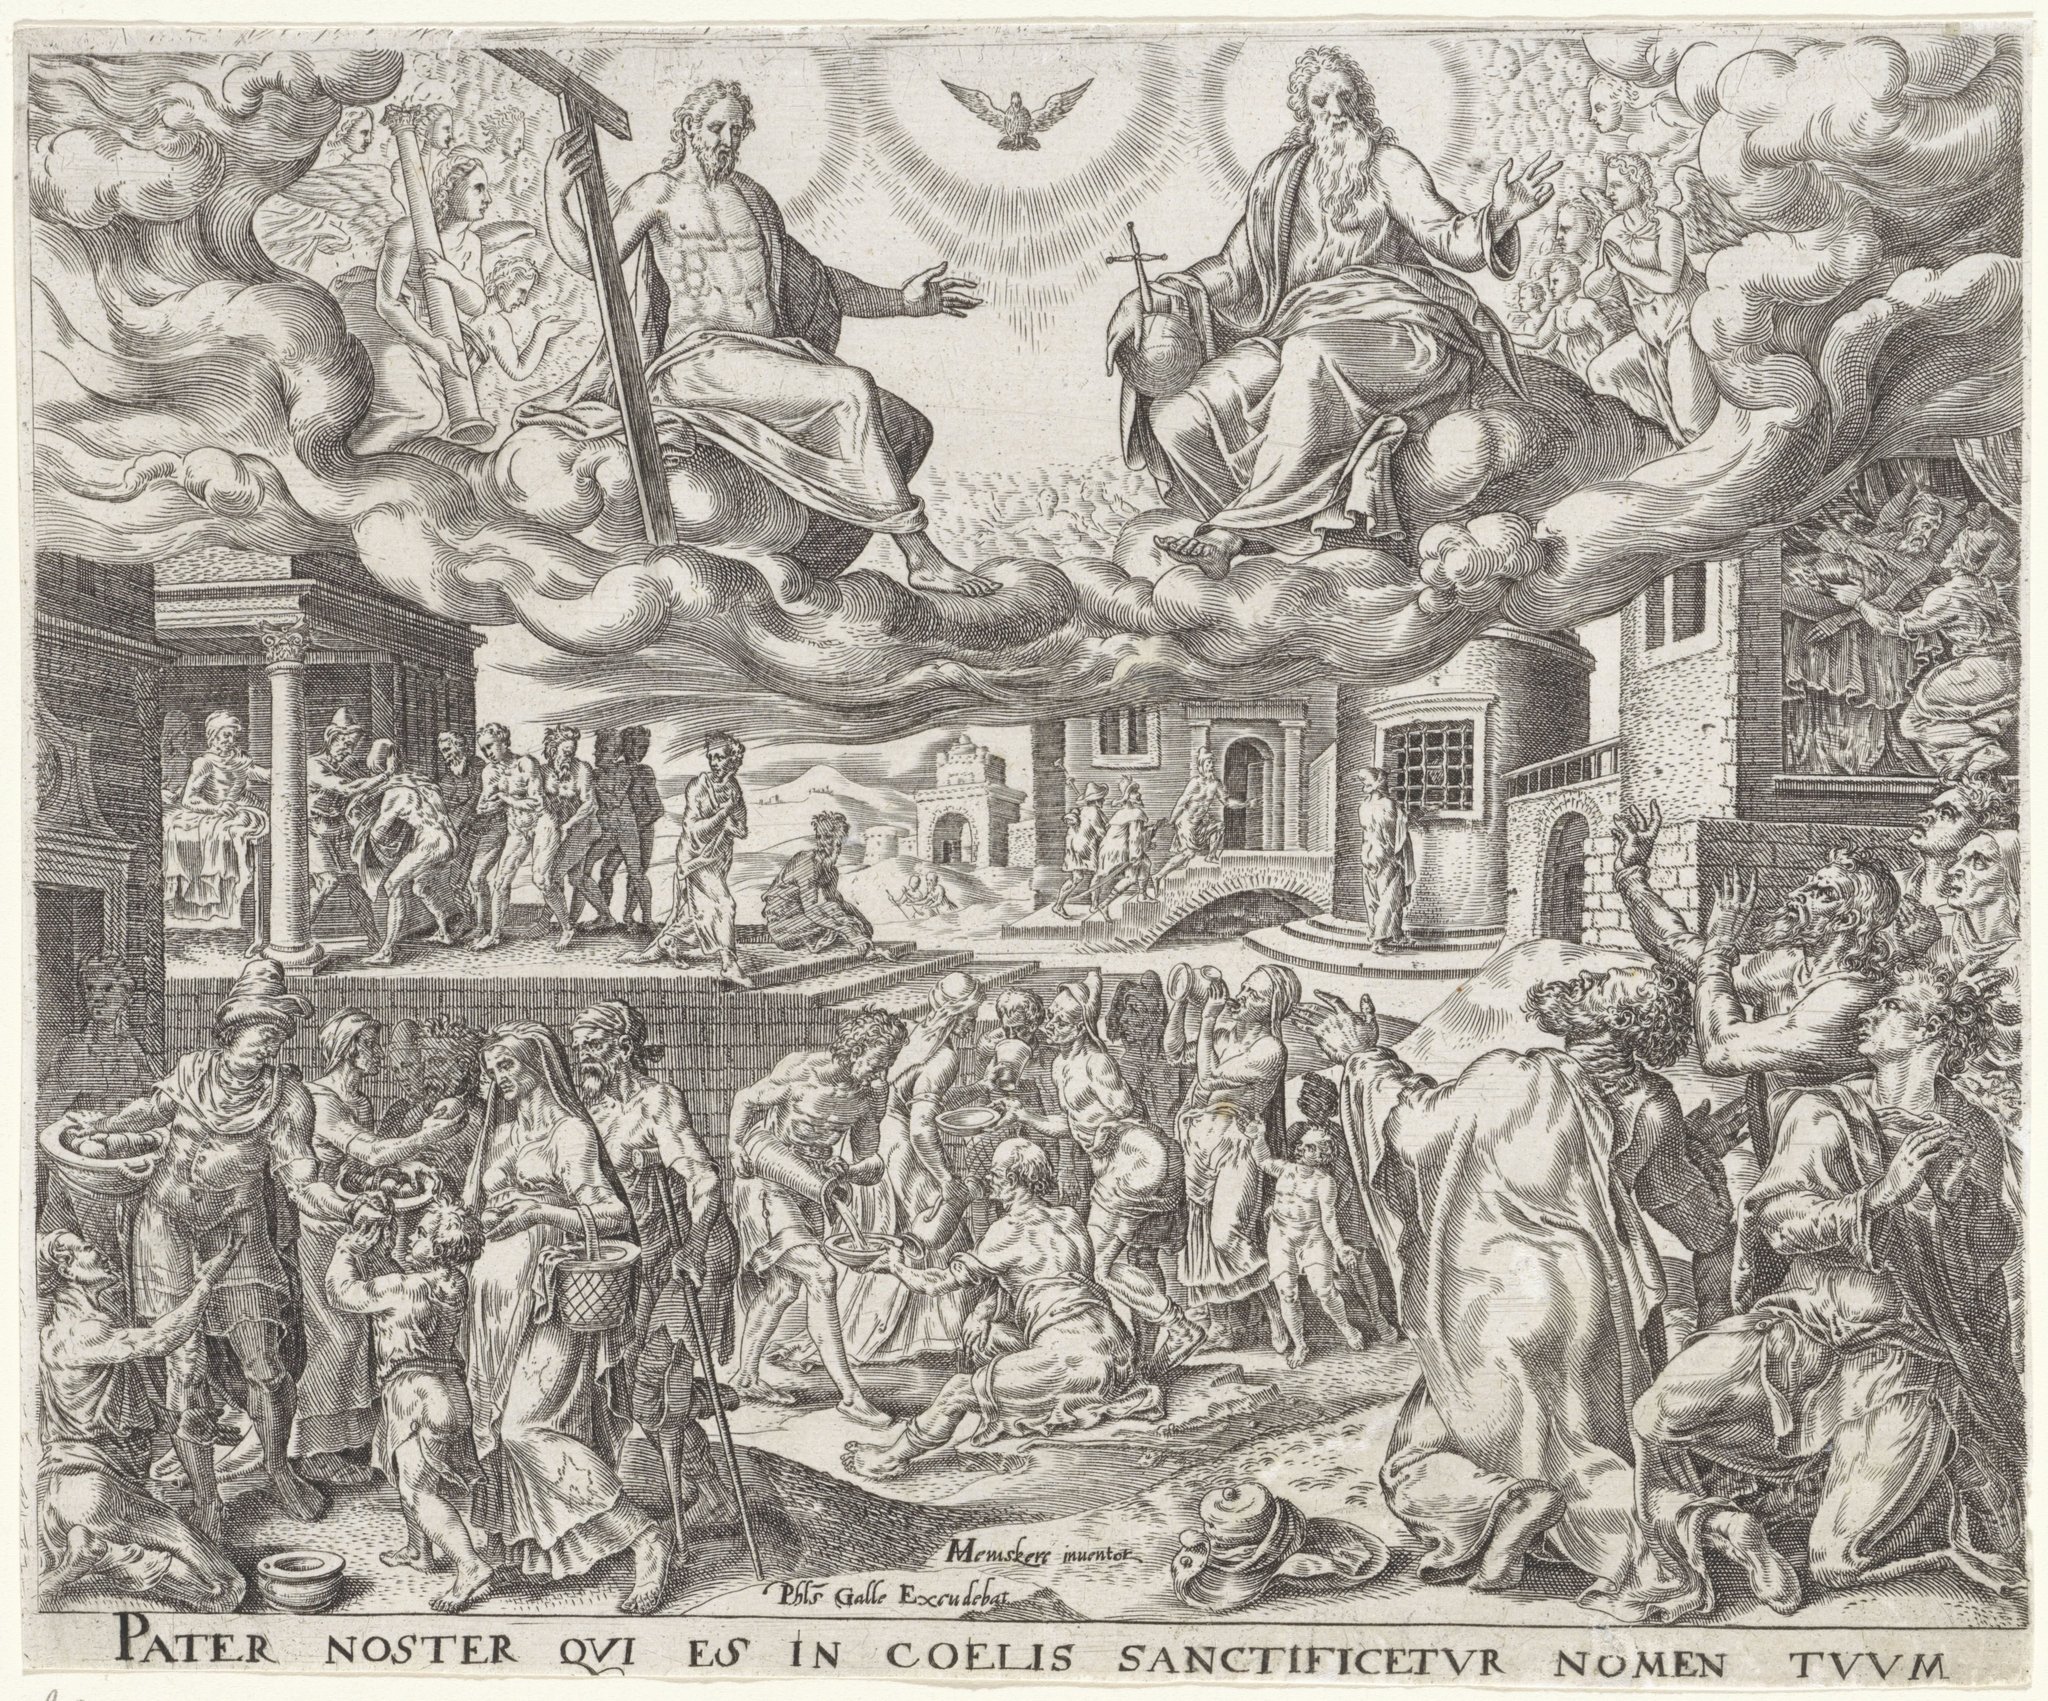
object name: print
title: Onze Vader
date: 1569-1573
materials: paper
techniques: engraving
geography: antwerp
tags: the holy trinity, 'trinitas coelestis'; father, son and holy ghost ~ christian religion, the (seven) acts of mercy, 'hallowed be thy name' ~ the lord's prayer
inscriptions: collector's mark: Lugt 2228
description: Geknielde mannen en vrouwen bidden richting de hemel. In de wolken de Drieëenheid, omringd door engelen. Op de aarde is te zien dat gelovigen de werken van barmhartigheid verrichten: de hongerigen spijzen, de dorstigen te drinken geven, de zieken en gevangenen bezoeken, de naakten kleden, de vreemdeling huisvesten en het begraven van de doden. Het Latijnse onderschrift is het eerste deel van het gebed het Onze Vader.